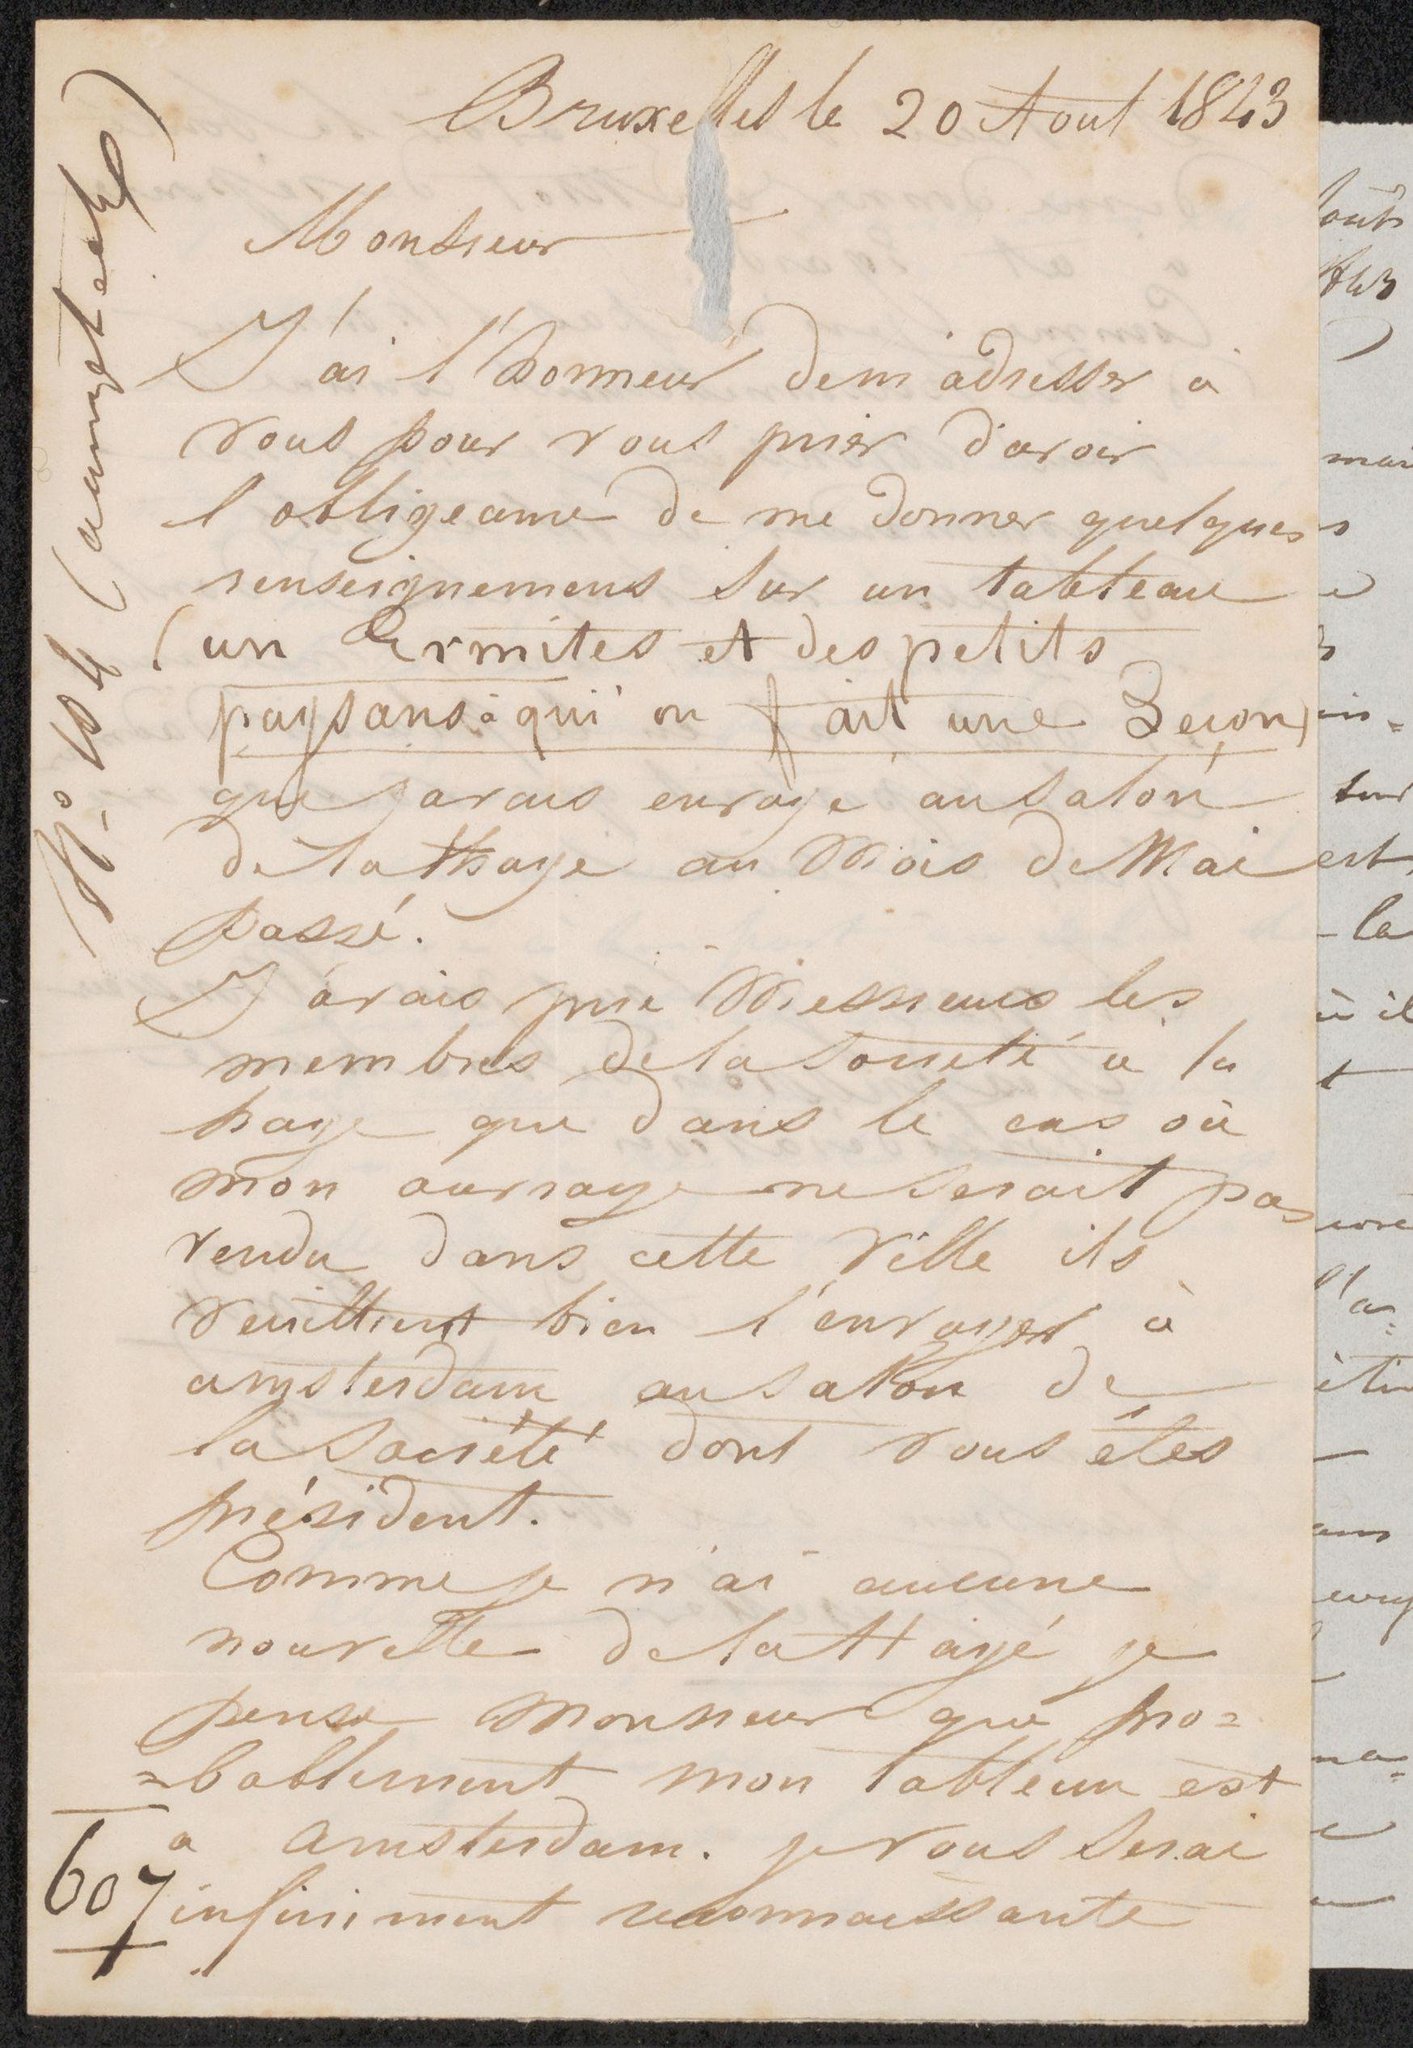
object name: letter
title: Brief aan Jan Willem Pieneman, voorzitter van Arti et Amicitiae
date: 1843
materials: ink, paper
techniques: pen, writing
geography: brussels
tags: painting (including book-illumination, miniature-painting), exhibition ~ art, the hague, amsterdam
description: Brief bevat geschreven kopie van het antwoord van Jan Willem Pieneman aan Adèle Kindt.